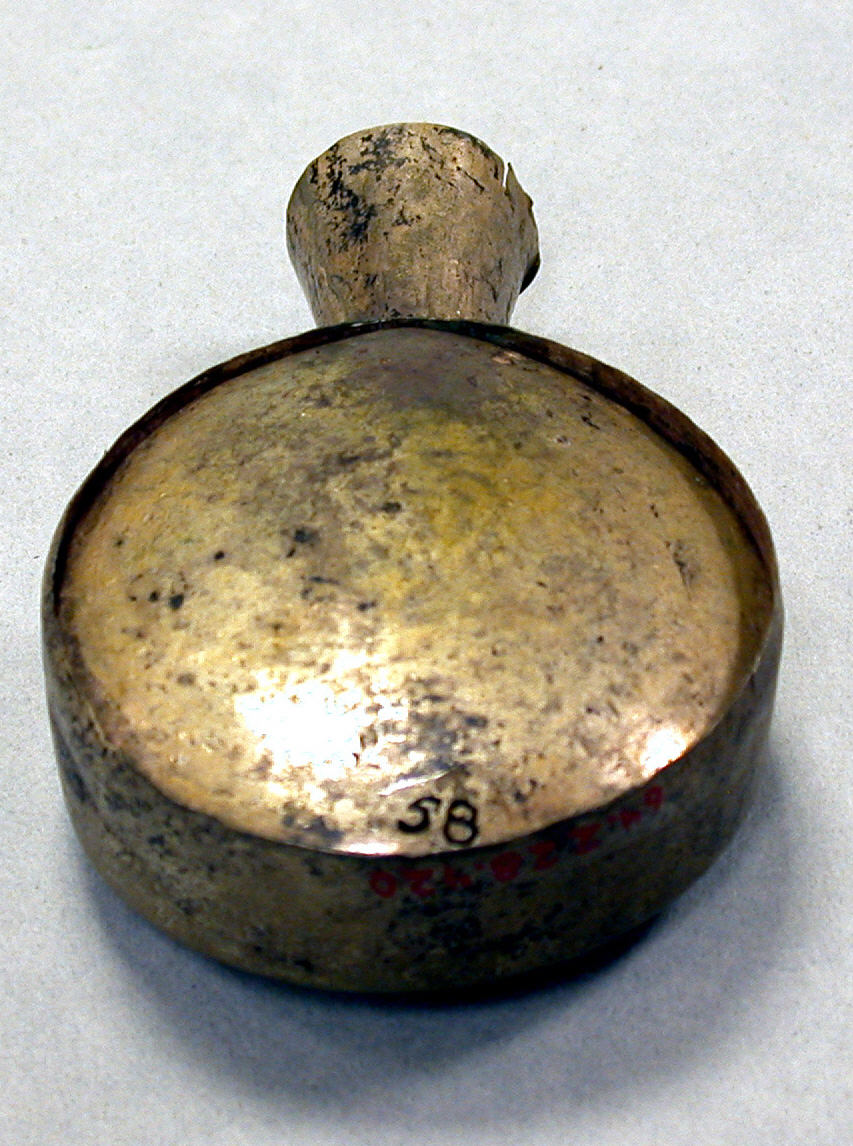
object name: bottle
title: Miniature Bottle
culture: chancay or chimú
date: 1001-1500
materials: gilt, silver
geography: peru